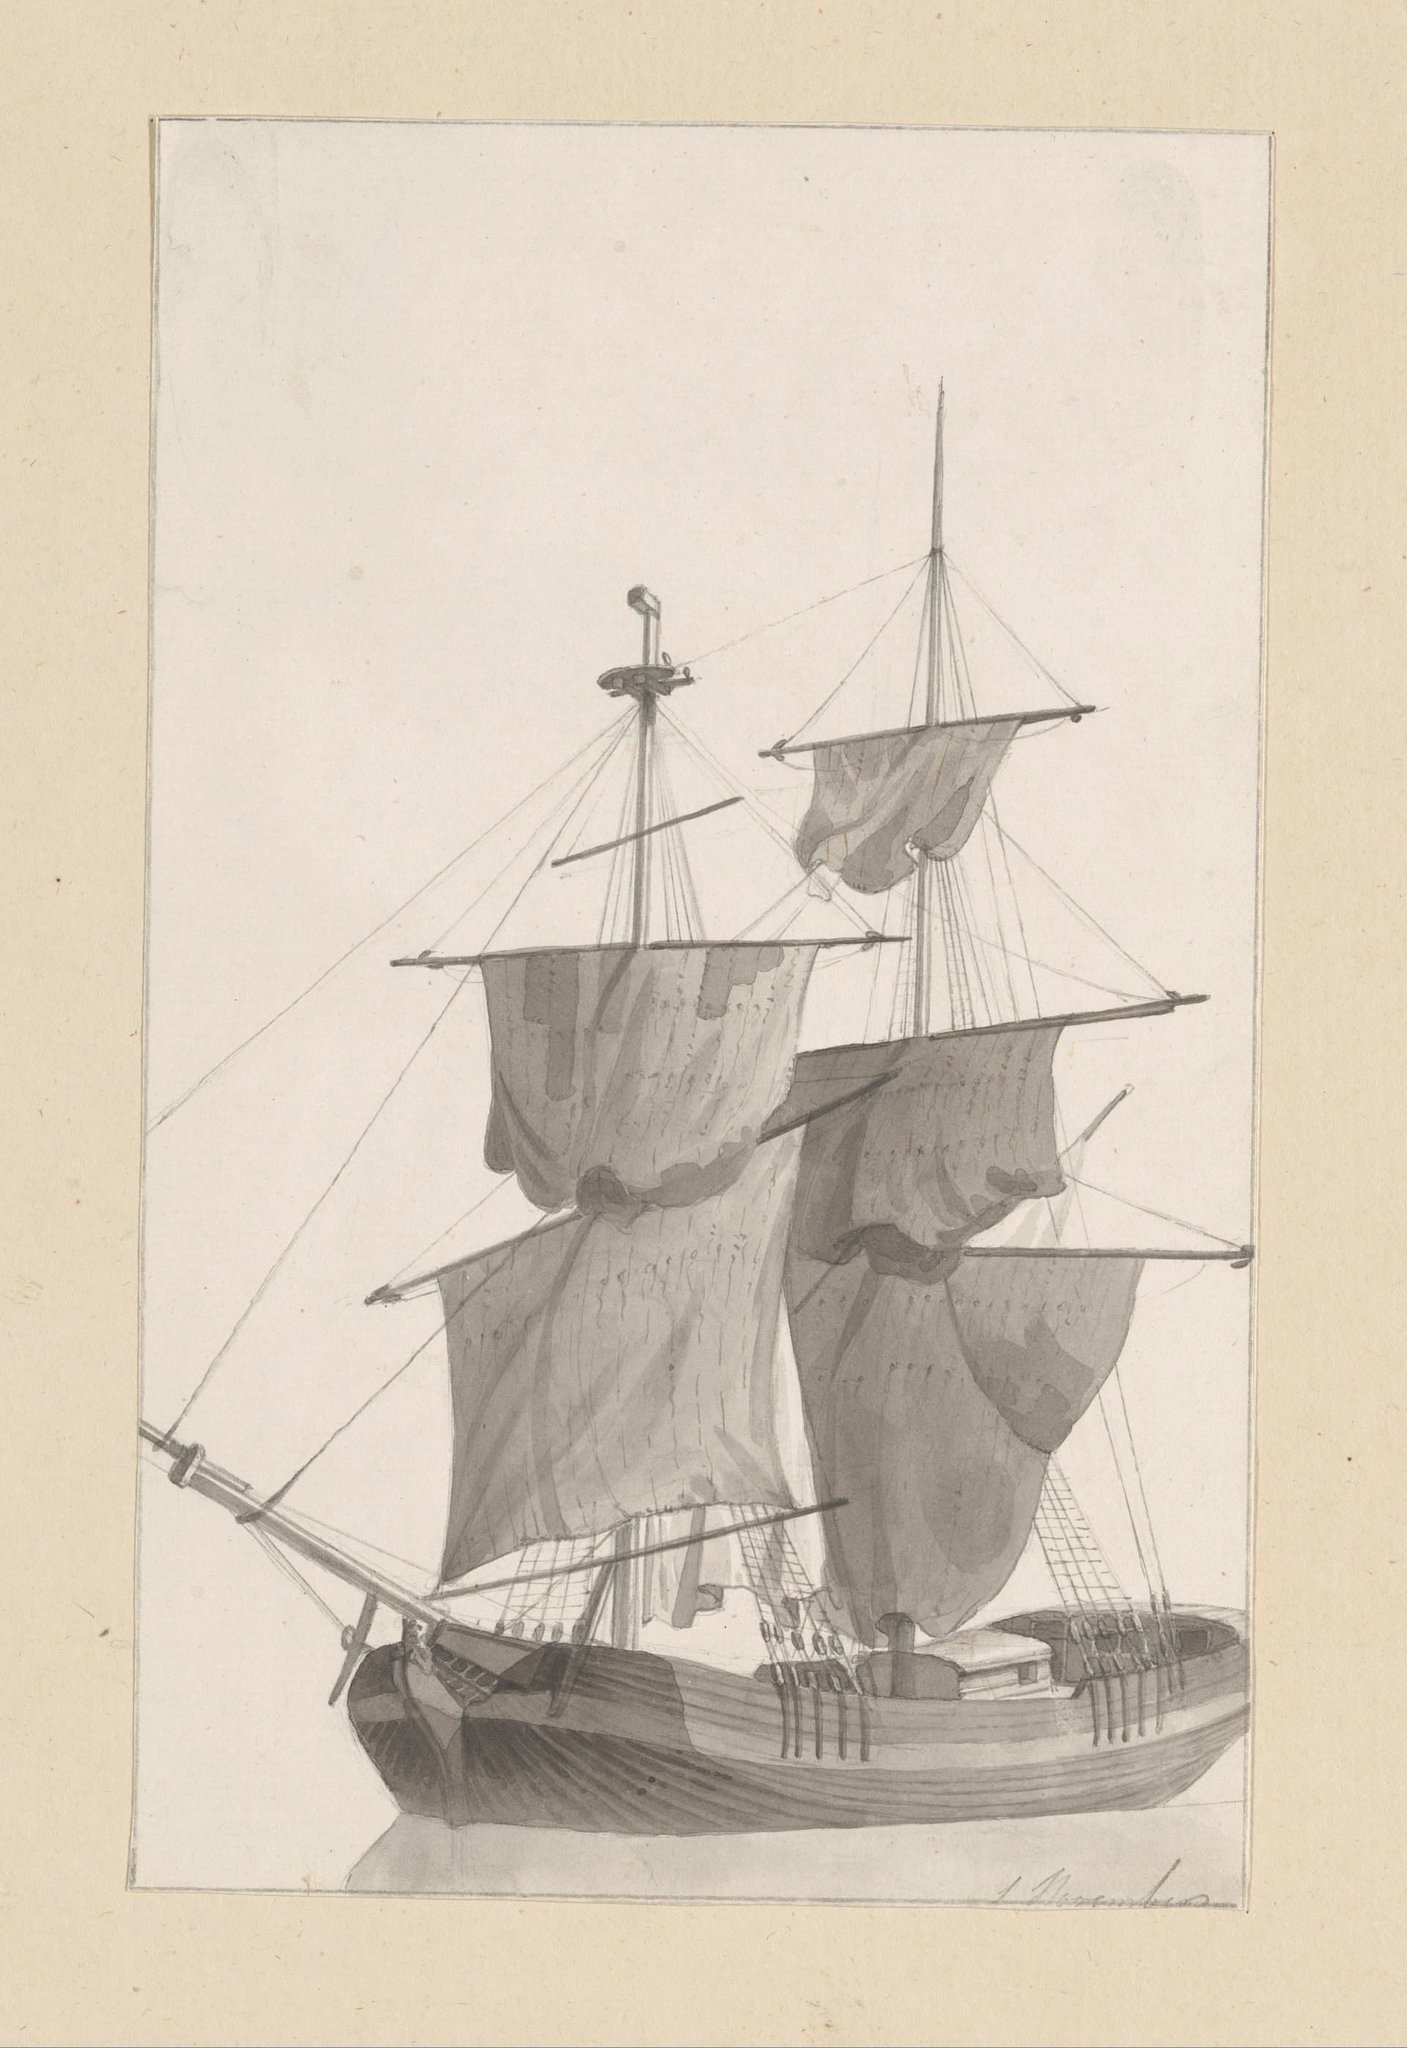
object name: drawing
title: Zeilschip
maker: hendrik abraham klinkhamer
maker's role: draughtsman, painter, print maker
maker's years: 1810-1872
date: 1820-1872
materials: paper, pencil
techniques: brush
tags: sailing-ship, sailing-boat